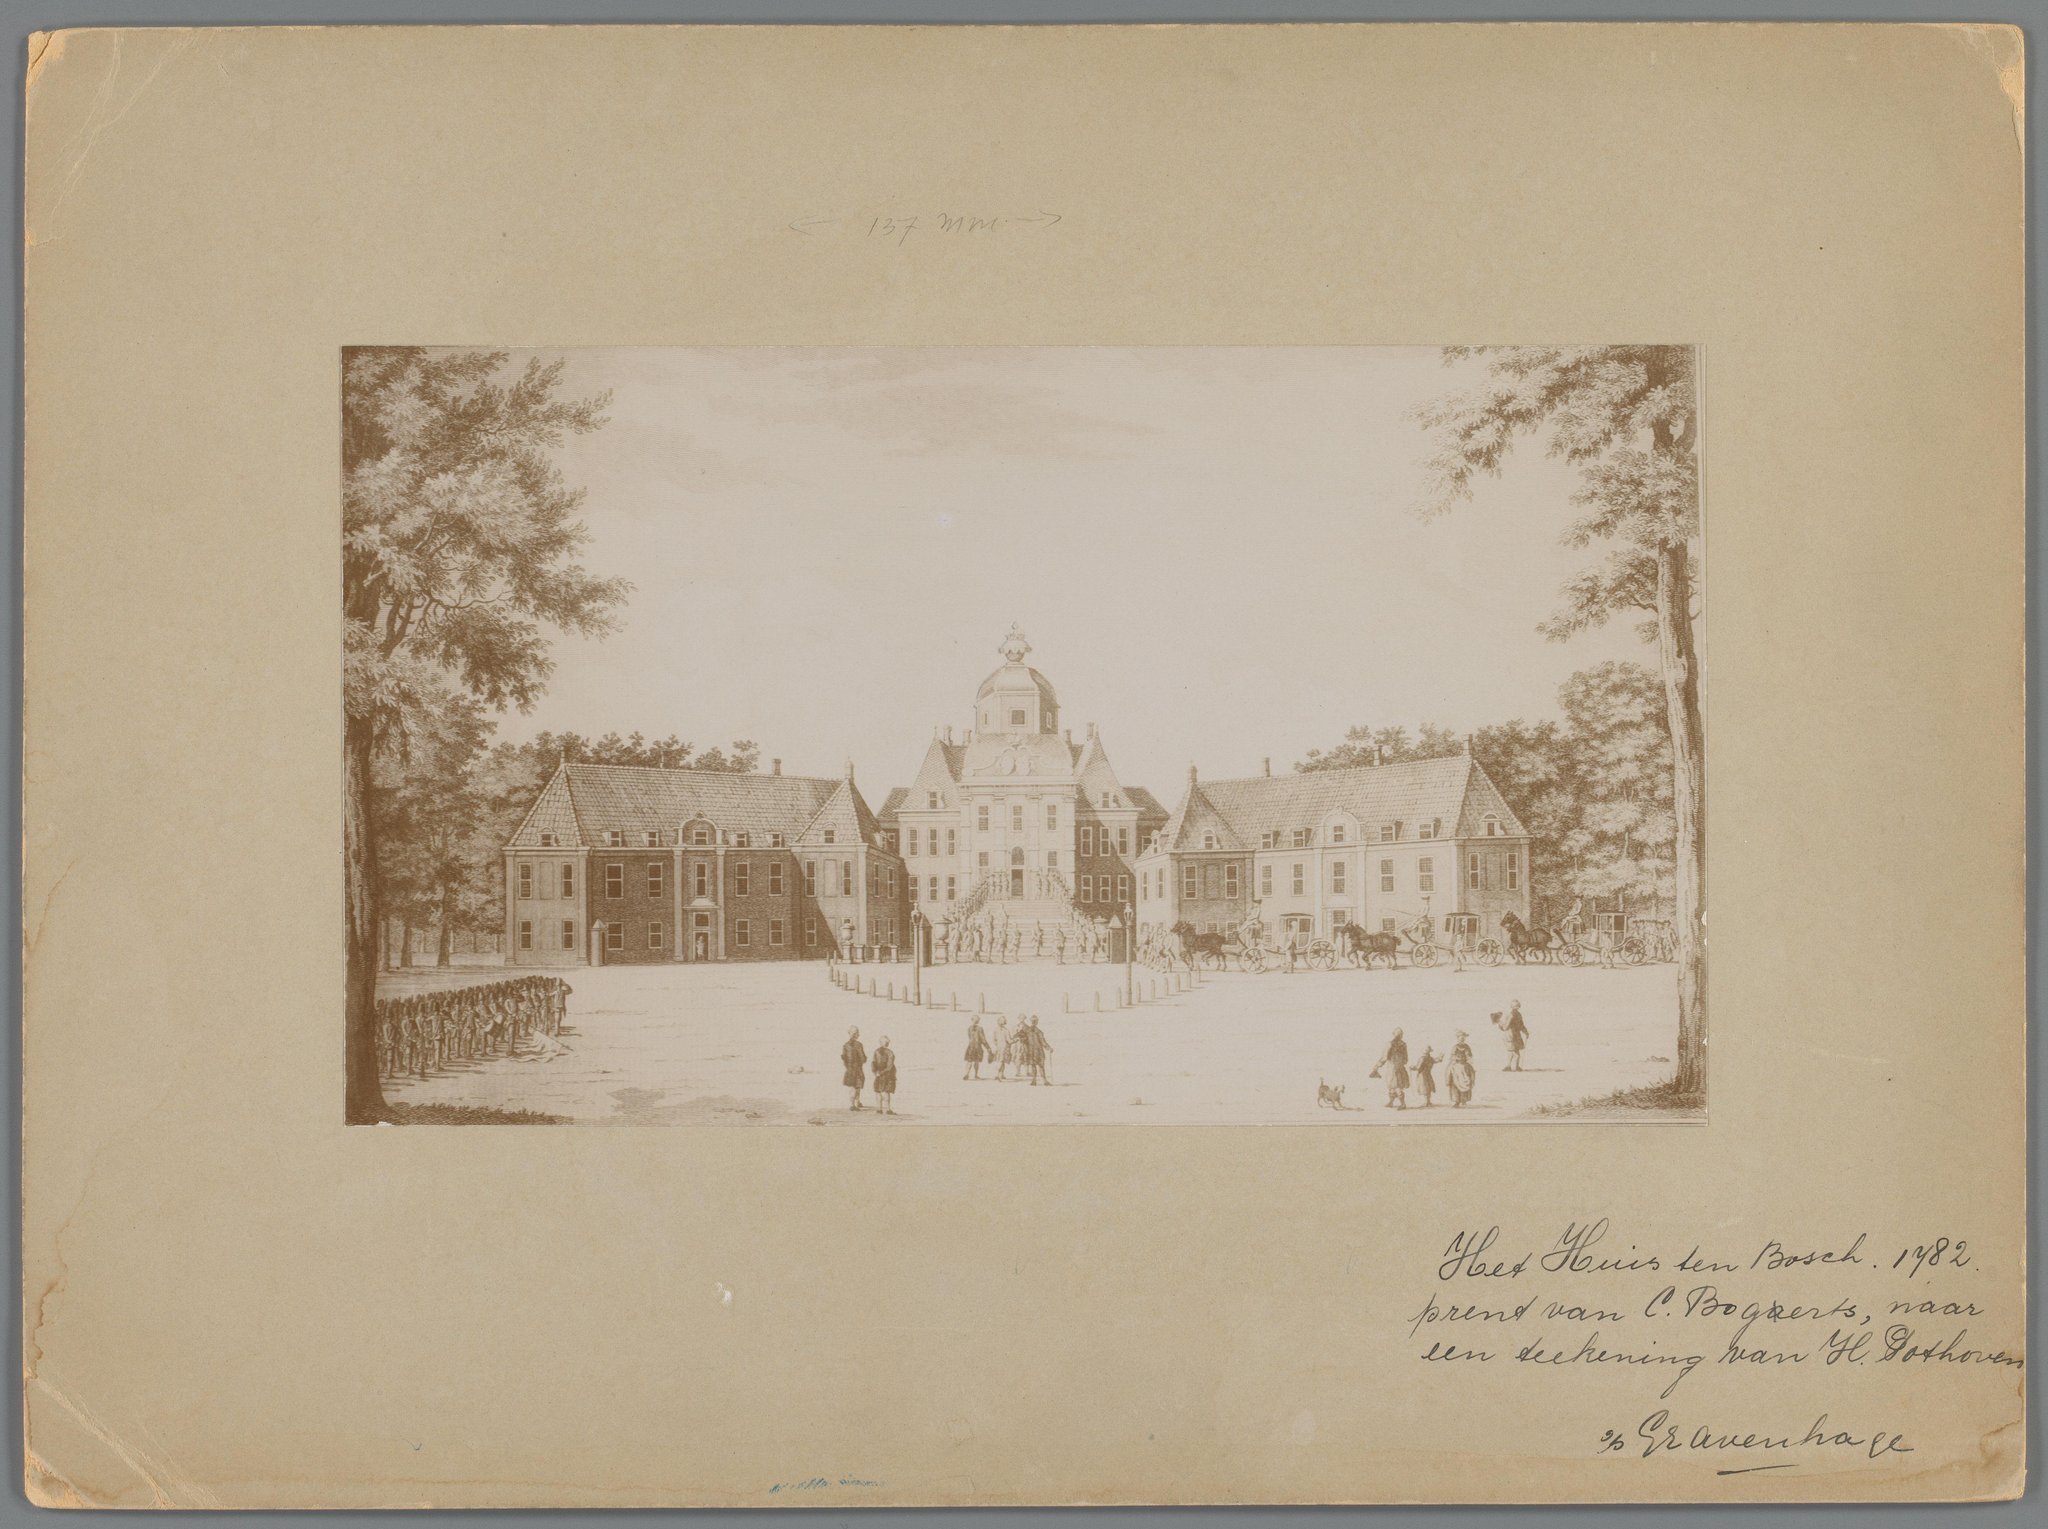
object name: reproduction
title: Het Huis ten Bosch, 1782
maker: Anonymous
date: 1890-1920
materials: paper, cardboard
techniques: gelatin silver print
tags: palace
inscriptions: inscription: ‘top. atlas RPK’, inscription: ‘v. Thiel, afb. 1’, inscription: ‘137 mm’, inscription: ‘Het Huis ten Bosch, 1782./ prent van C. Bogaerts, naar/ een teekening van H. Pothoven./ 's Gravenhage’, number: ‘2007’, collector's mark: Lugt 2228